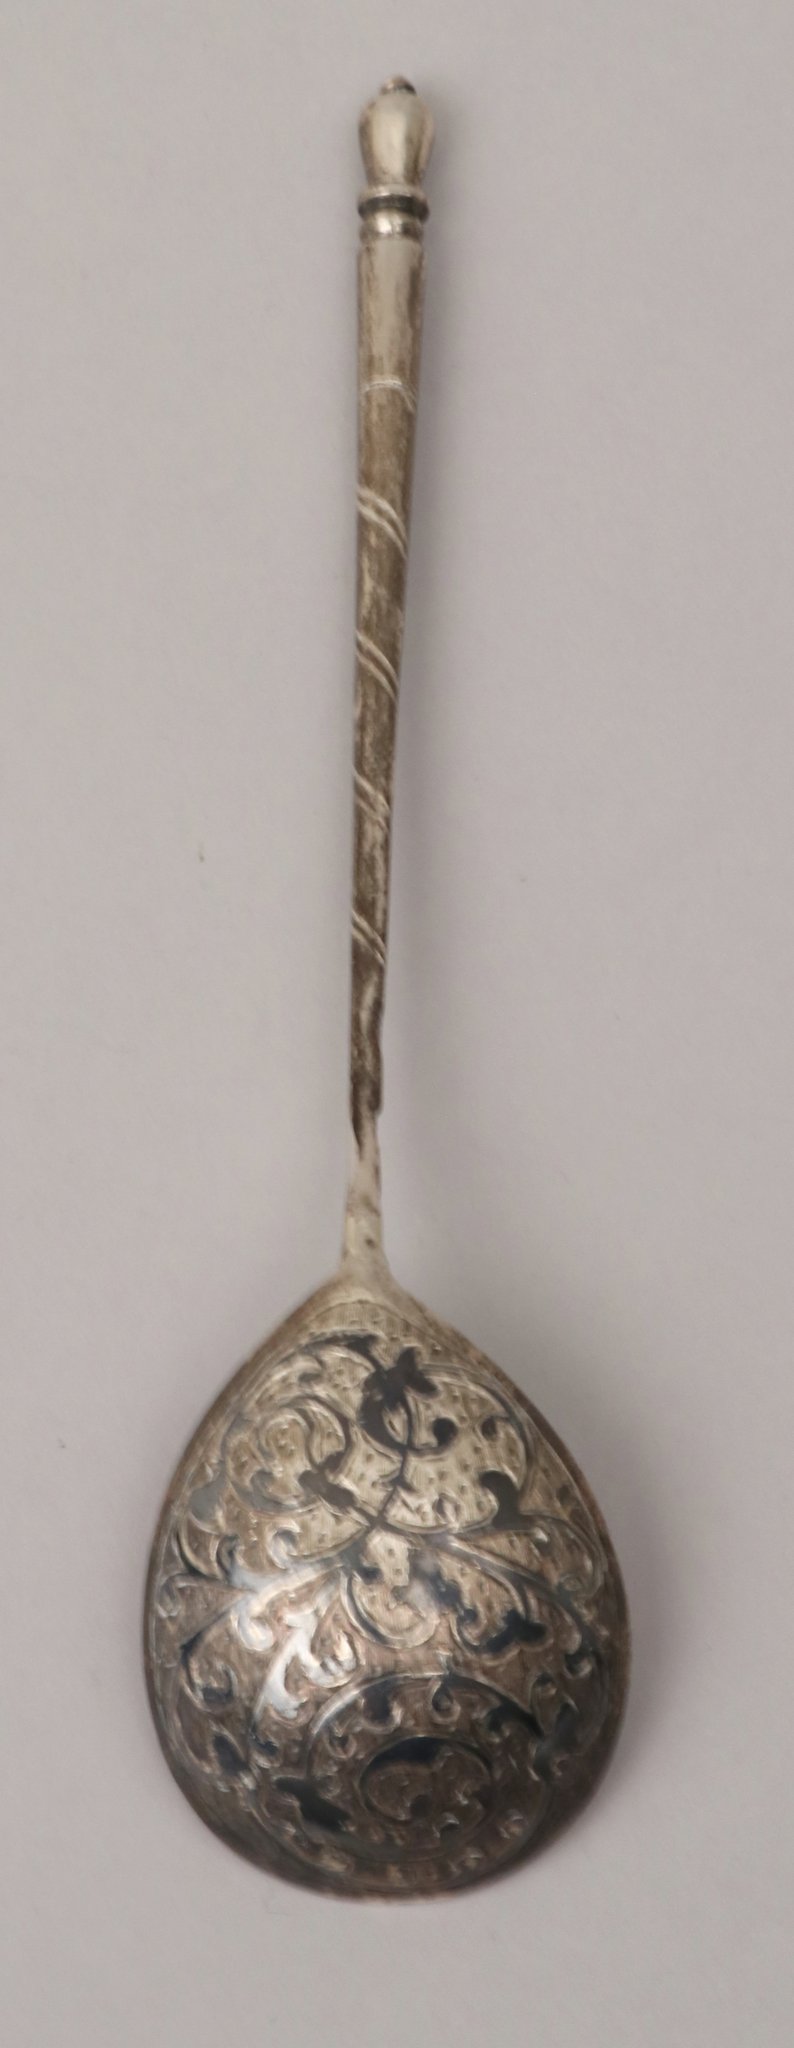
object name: spoon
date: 1866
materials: gilt, niello, silver